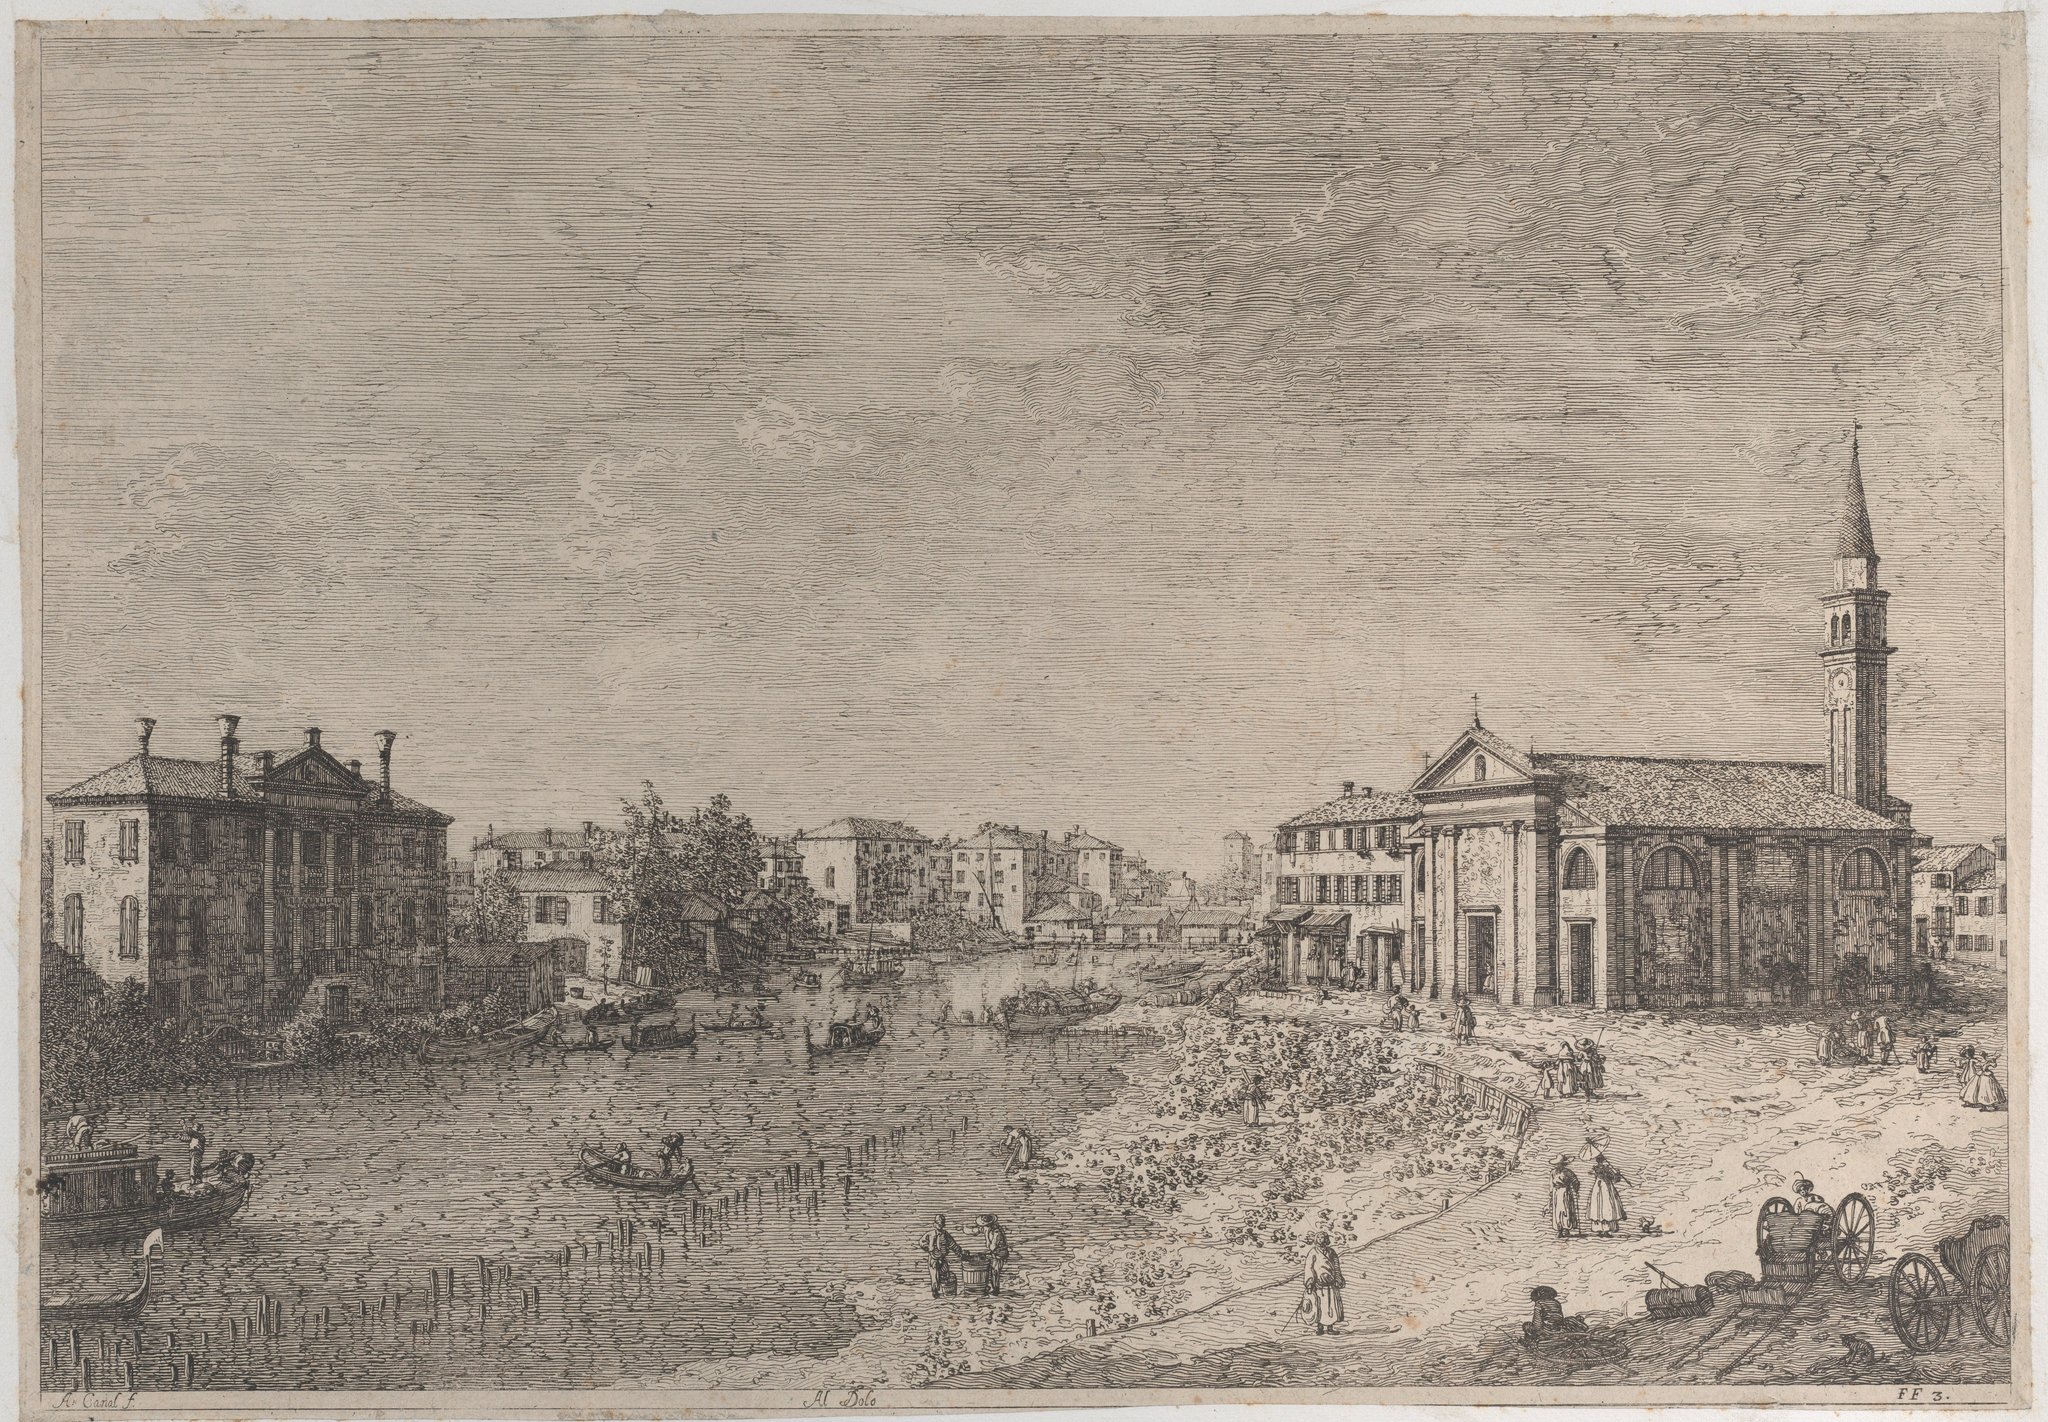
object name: print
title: Al Dolo: the church of Dolo, dedicated to San Rocco, on the bank of the Brenta, facing the villa Zanon-Bon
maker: canaletto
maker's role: artist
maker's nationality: italian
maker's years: 1697-1768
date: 1735-1746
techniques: etching